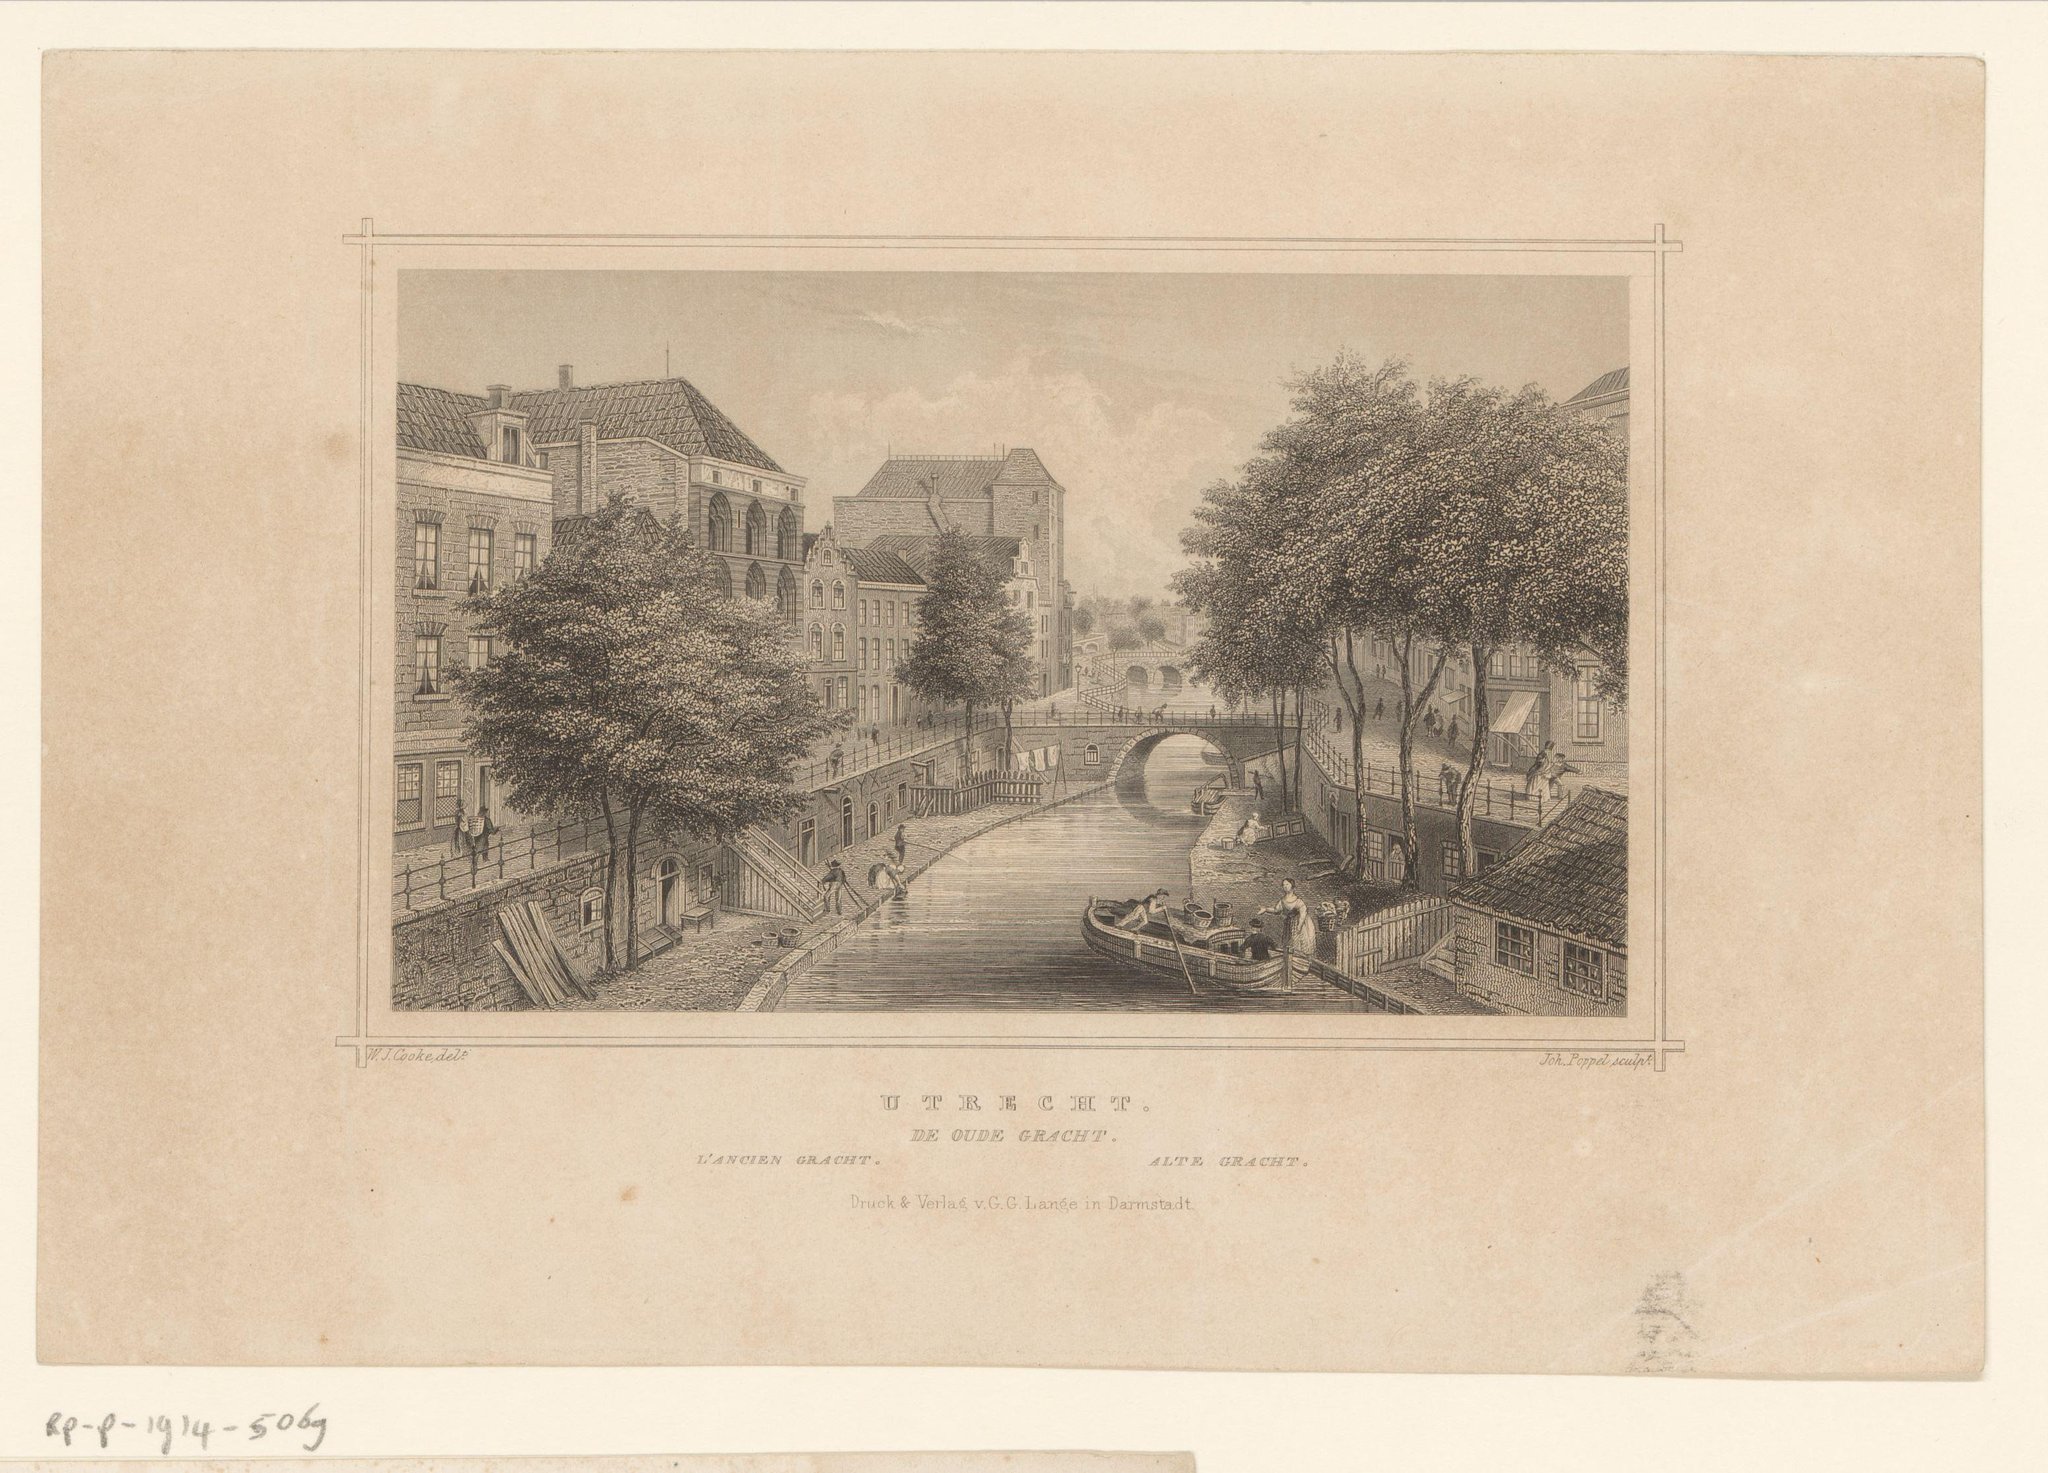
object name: print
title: Gezicht op de Oude Gracht in Utrecht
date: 1858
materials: paper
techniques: engraving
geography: darmstadt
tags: city-view, and landscape with man-made constructions, canal, utrecht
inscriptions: collector's mark: Lugt 2228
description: Prent ook gebruikt in: Terwen, Johannes Leonardus. Het Koningrijk der Nederlanden voorgesteld in eene reeks van naar de natuur geteekende schilderachtige gezigten. Gouda: Van Goor, 1858-1862.